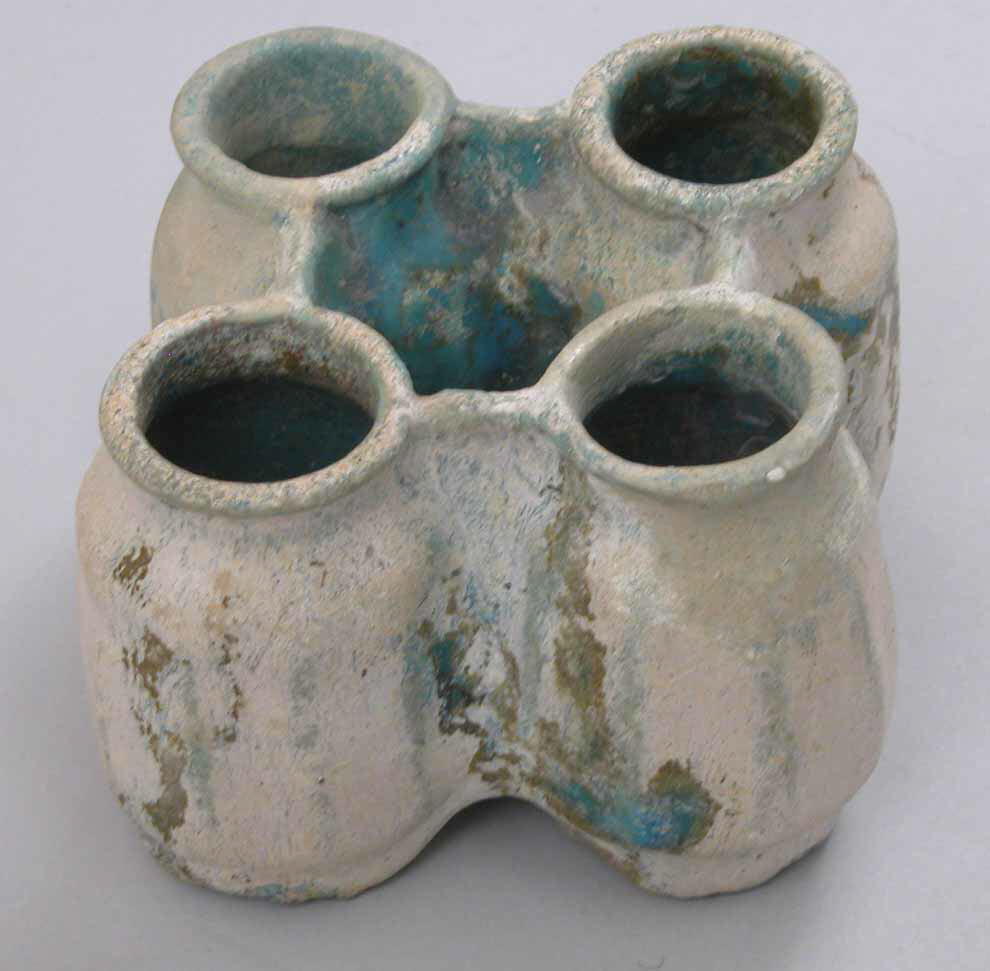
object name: vase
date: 1101-1200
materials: earthenware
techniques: glazing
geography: iran